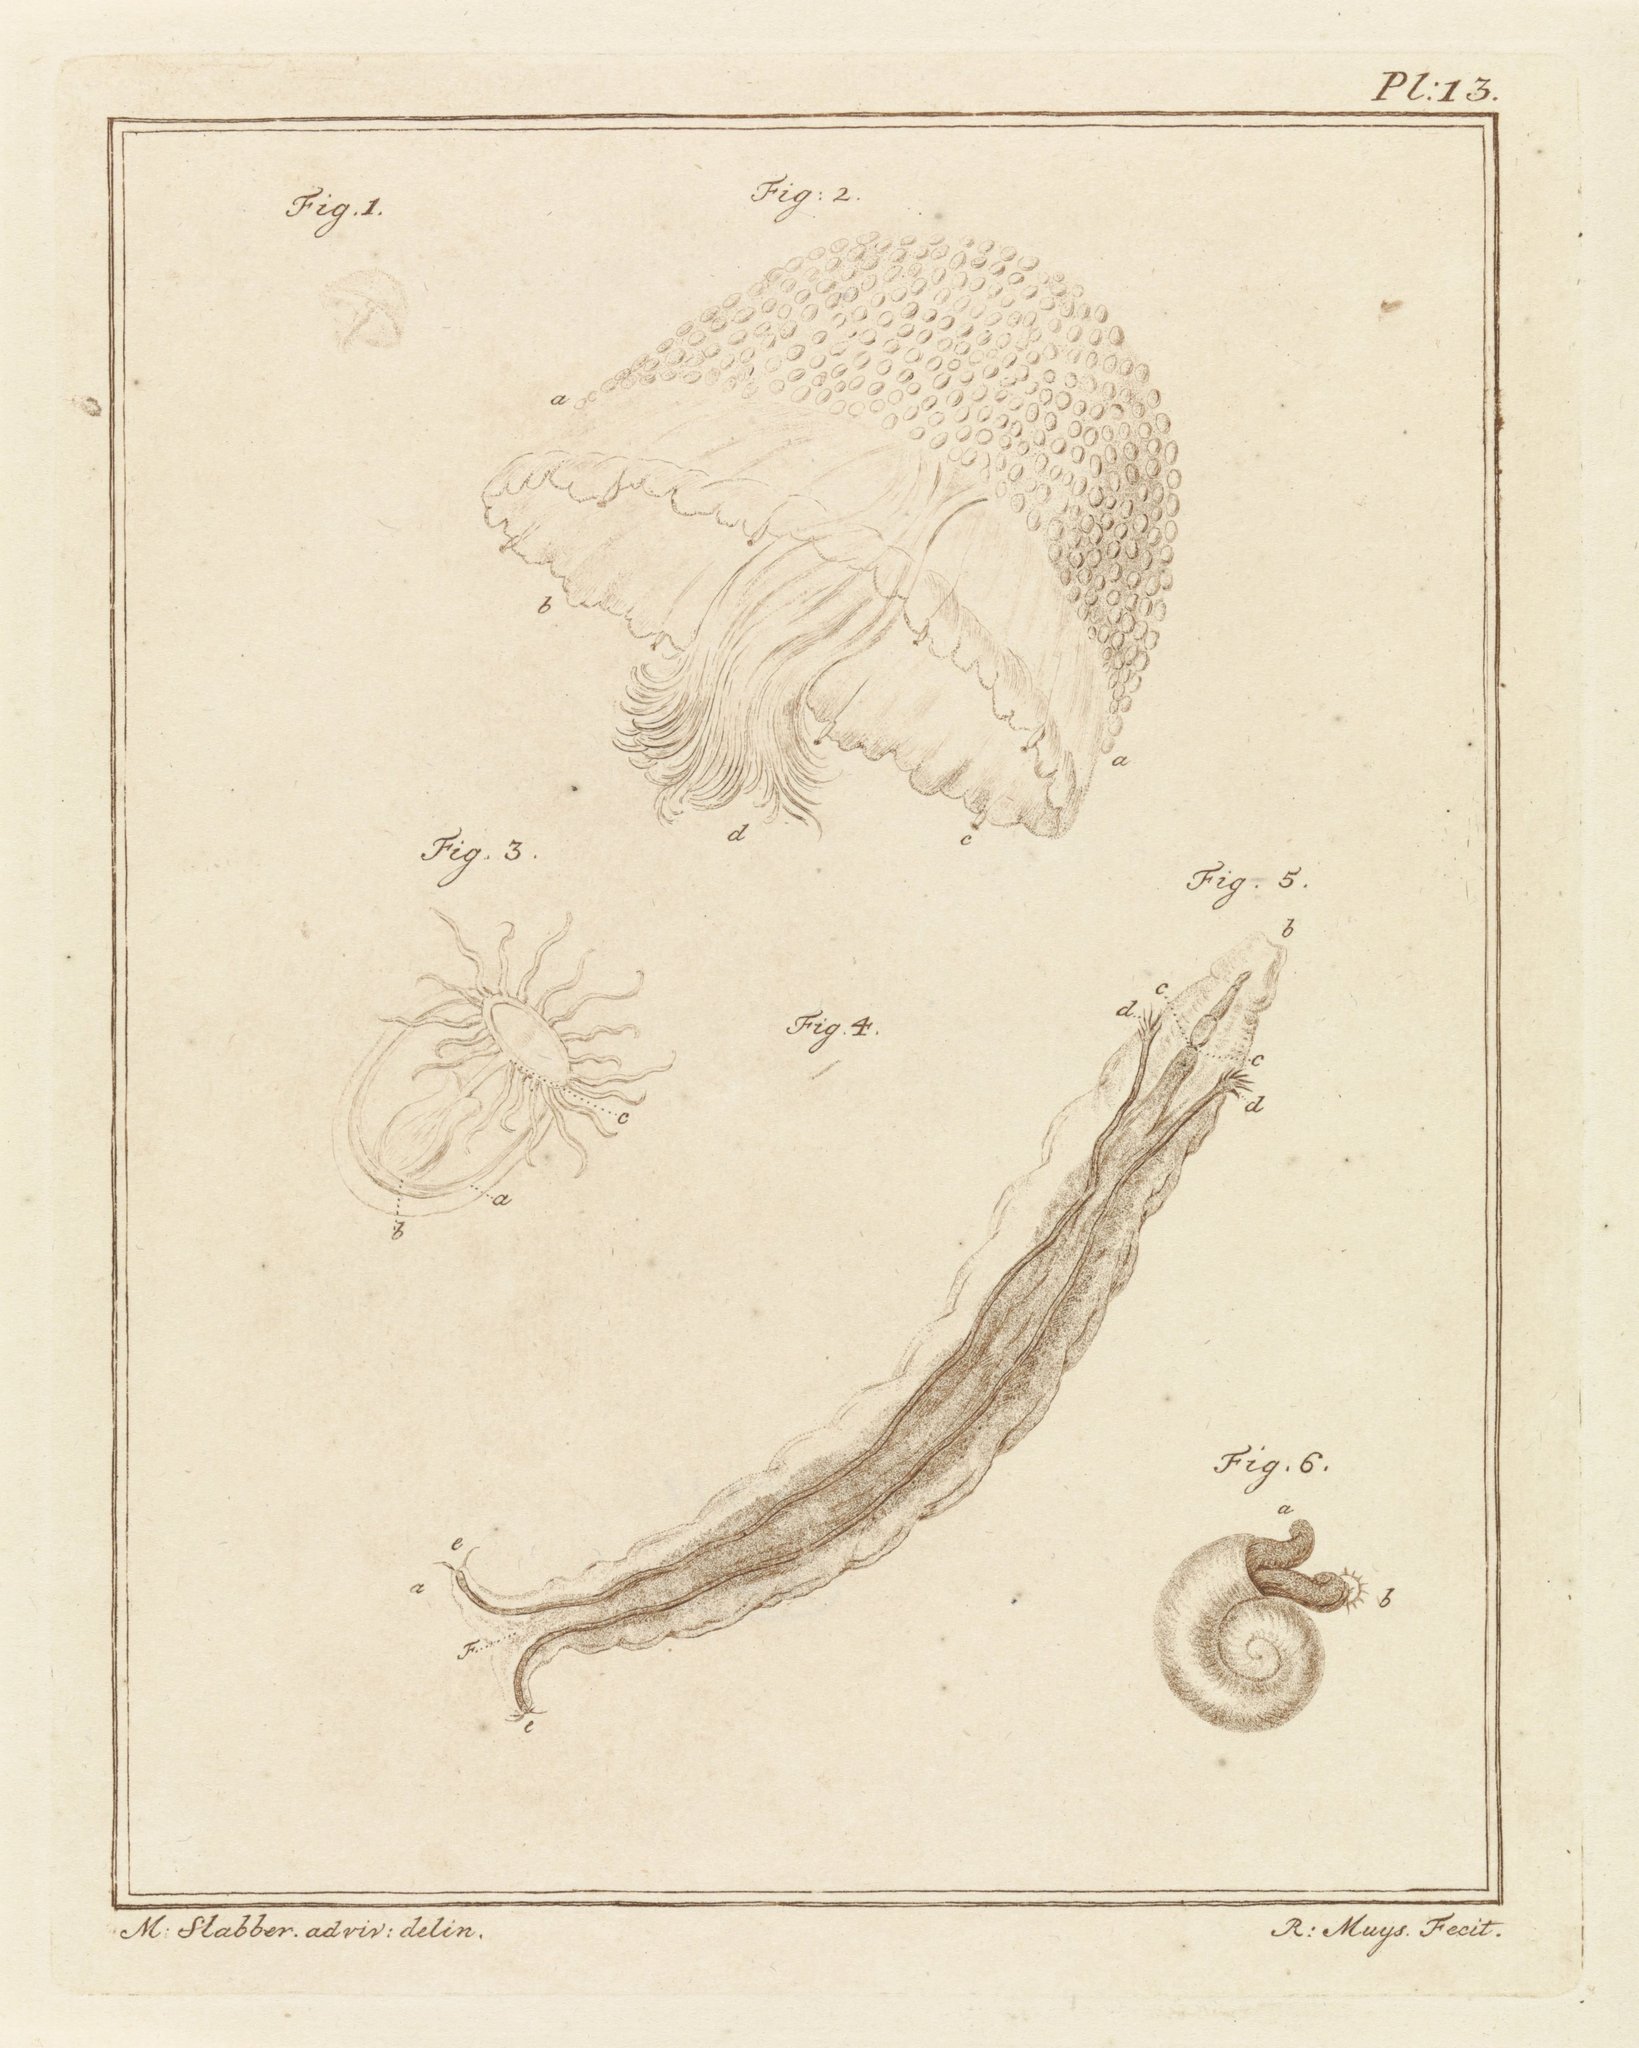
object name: book illustration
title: Diverse zeedieren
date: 1778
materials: paper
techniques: etching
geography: rotterdam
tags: lower animals (+ animals ~ biological investigation)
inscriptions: collector's mark: Lugt 2228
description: Zeedieren. Figuur 1 en 2 tonen een parelkwal op ware grootte en uitvergroot. Figuur 3 toont een poliepkwalletje. Figuur 4 en 5 tonen een borstelworm op ware grootte en uitvergroot. Figuur 6 toont een larve van een zeeslak. Rechtsboven: Pl. 13. Prent uit een boek over binnen- en buitenlandse land- en waterdieren.